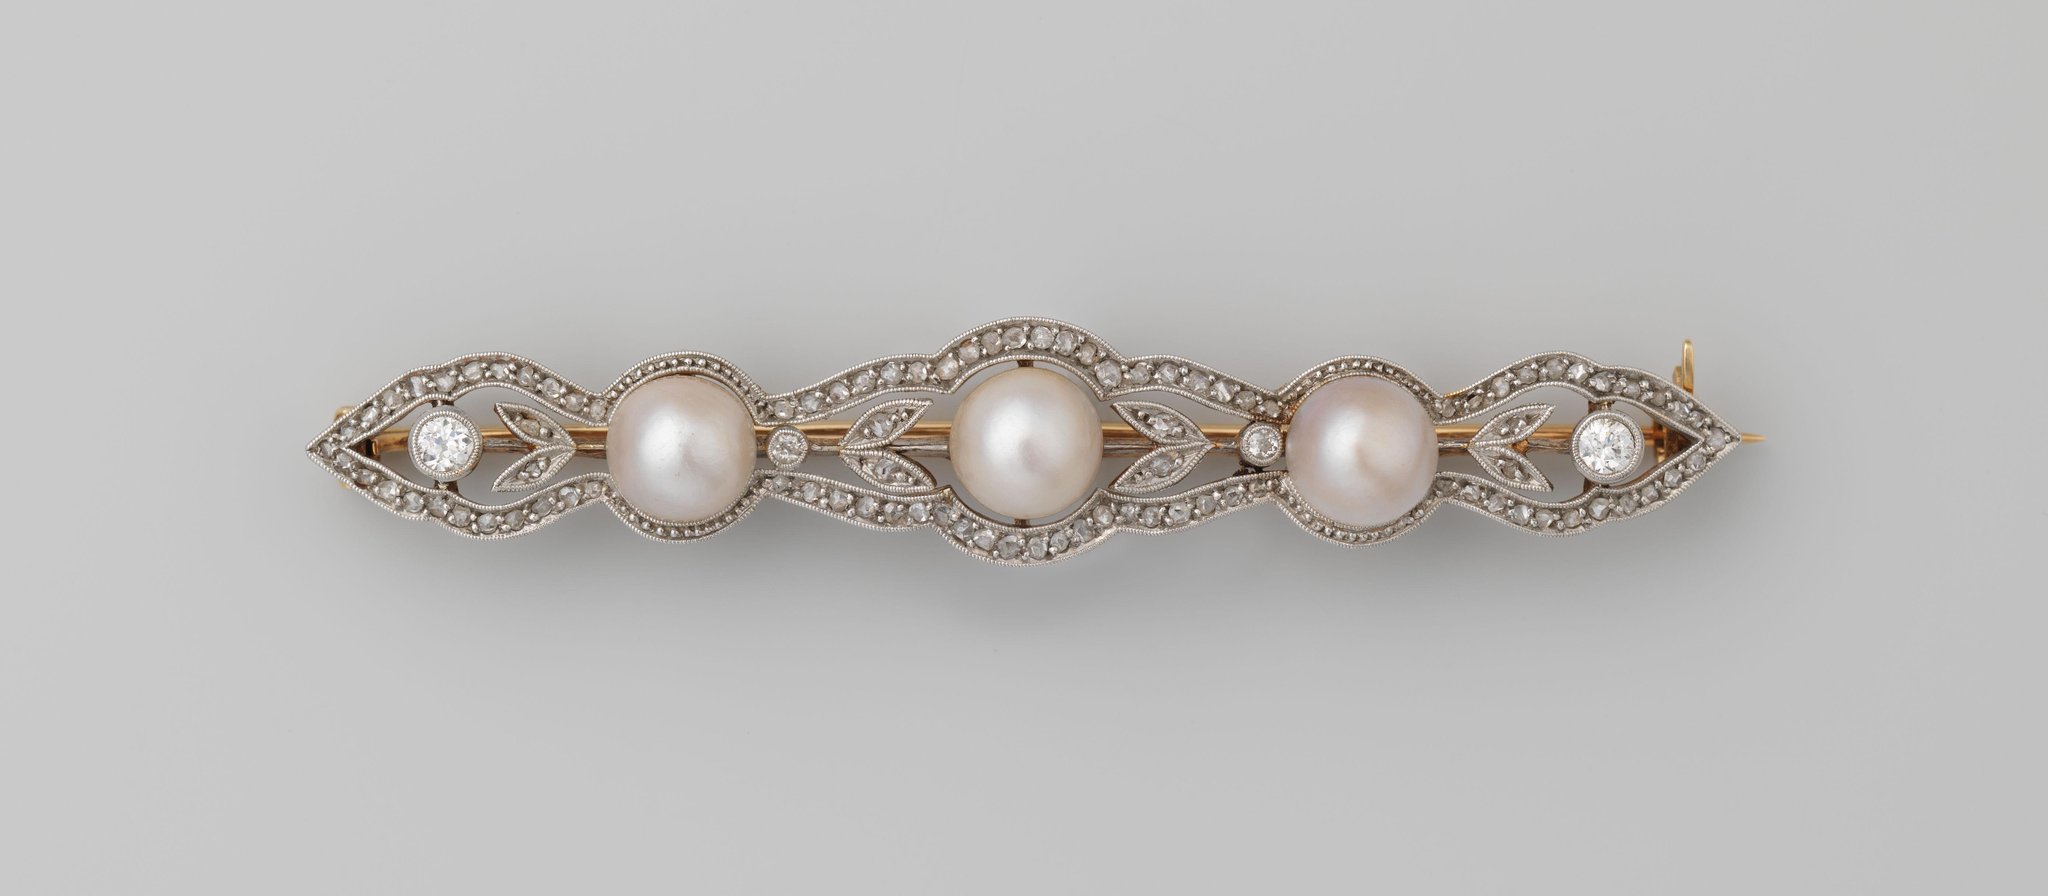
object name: brooch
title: Brochette van witgoud bezet met parels en diamanten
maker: m. katan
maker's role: jeweler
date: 1910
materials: diamond, pearl, gold alloy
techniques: faceting, grinding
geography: amsterdam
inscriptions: maker's mark: ‘M1K’, duty mark: ‘I’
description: Brochette van witgoud bezet met drie parels en twee diamanten oud slijpsel en vele kleine gefacetteerde diamanten.